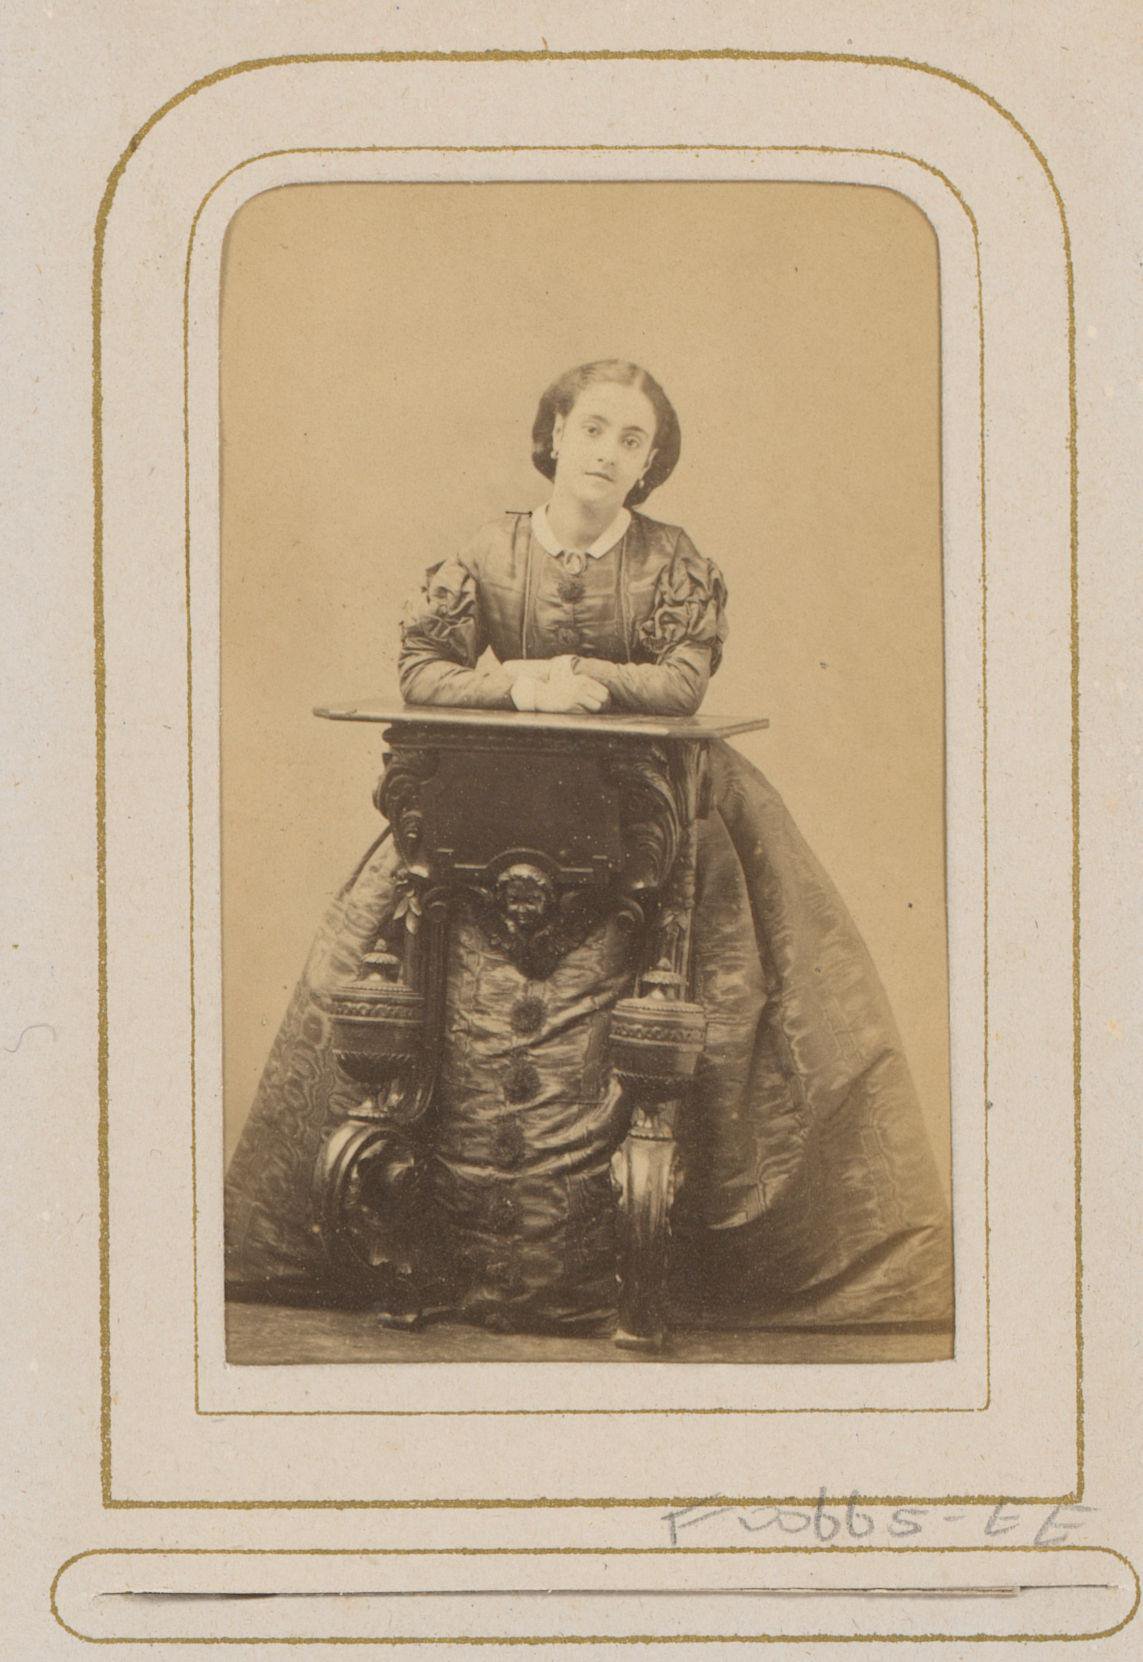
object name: album leaf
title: Portret van Adelina Patti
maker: jules géruzet (fotograaf)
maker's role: fotograaf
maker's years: 1817-1874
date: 1855-1880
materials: cardboard, photographic support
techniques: albumen print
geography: brussels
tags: historical persons - bb - woman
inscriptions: inscription: ‘Atelier de Photographie/ de J. Géruzet, Editeur d'Estampes/ 27bis, Rue de l'Ecuyer/ Bruxelles’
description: Portret van Adelina Patti leunend op tafel. Deze foto maakt deel uit van een album.